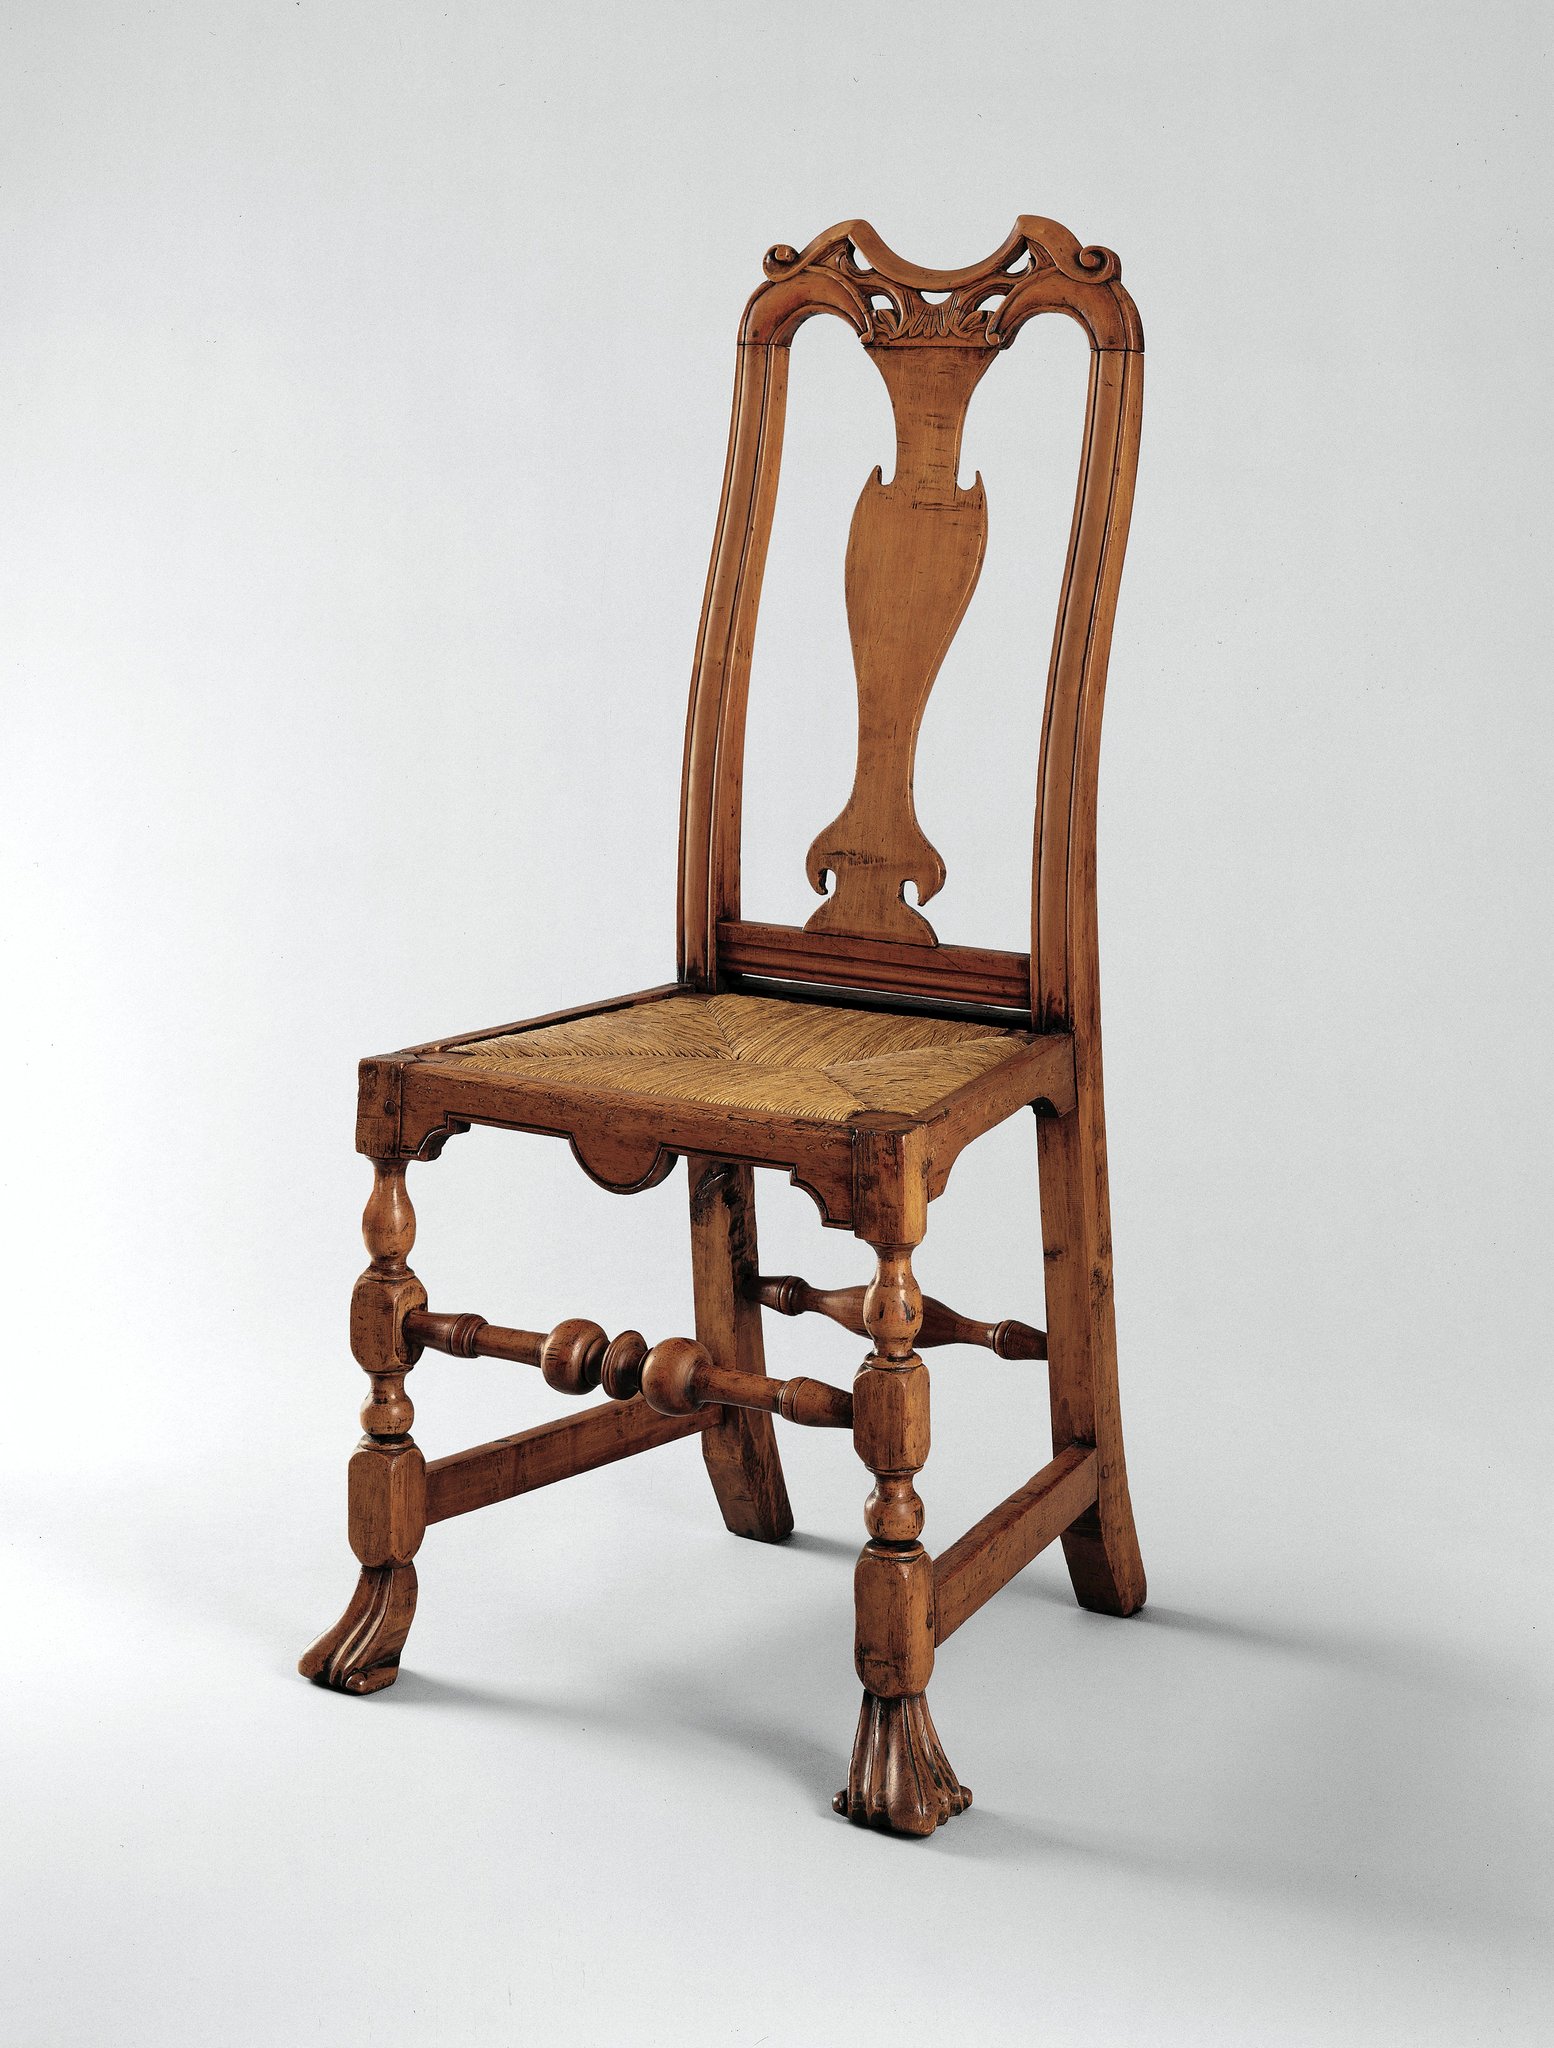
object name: side chair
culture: american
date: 1730-1750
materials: wood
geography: united states